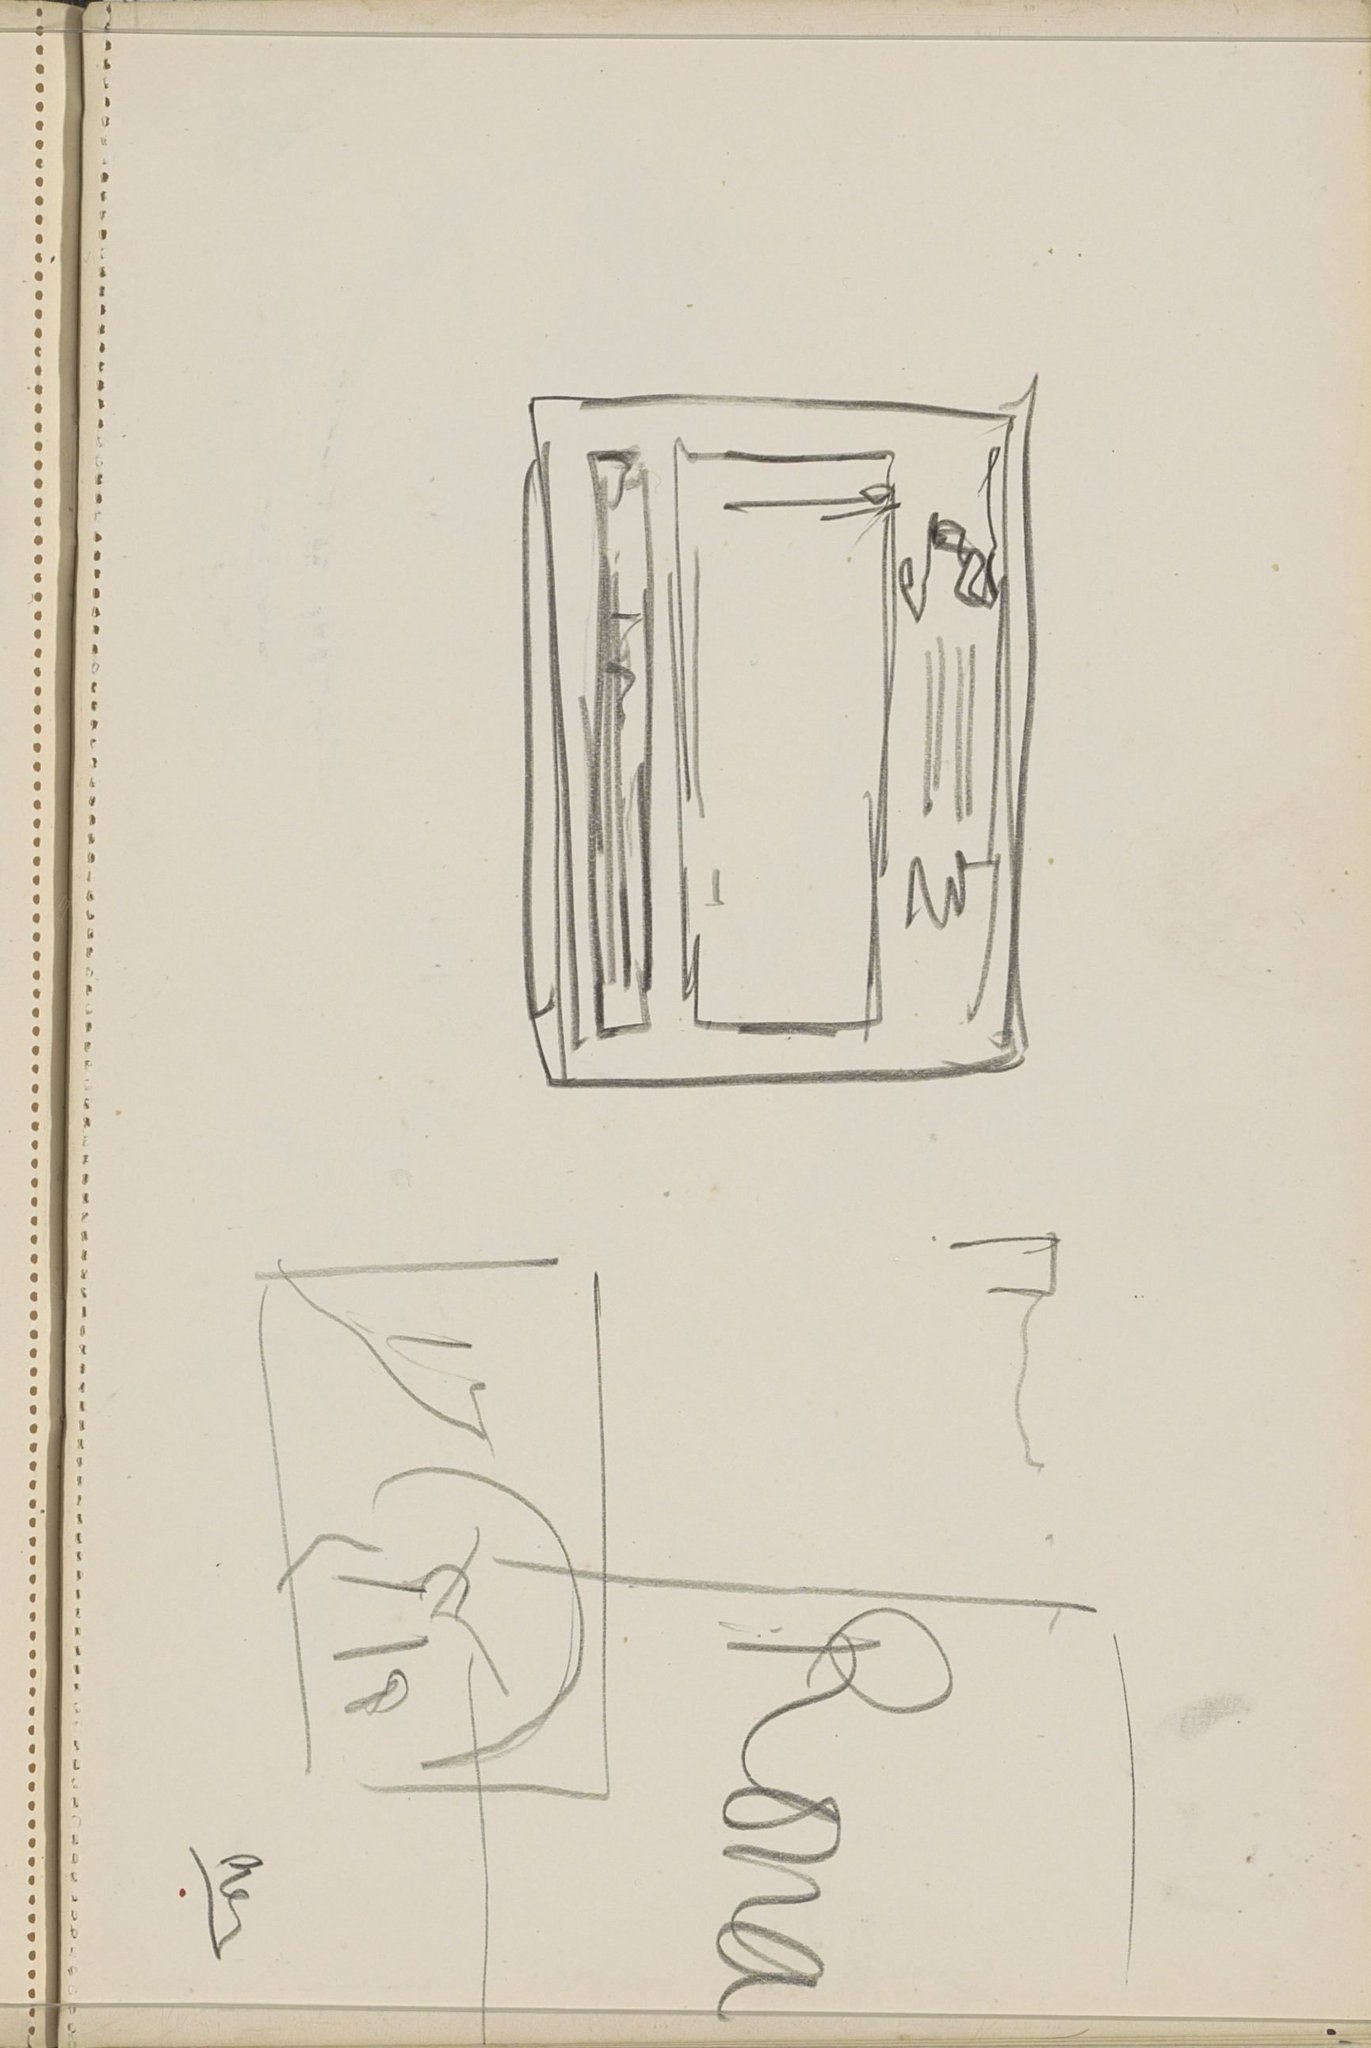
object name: sketchbook leaf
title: Ontwerp voor een blik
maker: cornelis vreedenburgh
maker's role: draughtsman, print maker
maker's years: 1880-1946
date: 1890-1946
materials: paper, pencil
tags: containers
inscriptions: annotation: ‘Rona’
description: Blad 43 recto uit een schetsboek met 59 bladen.